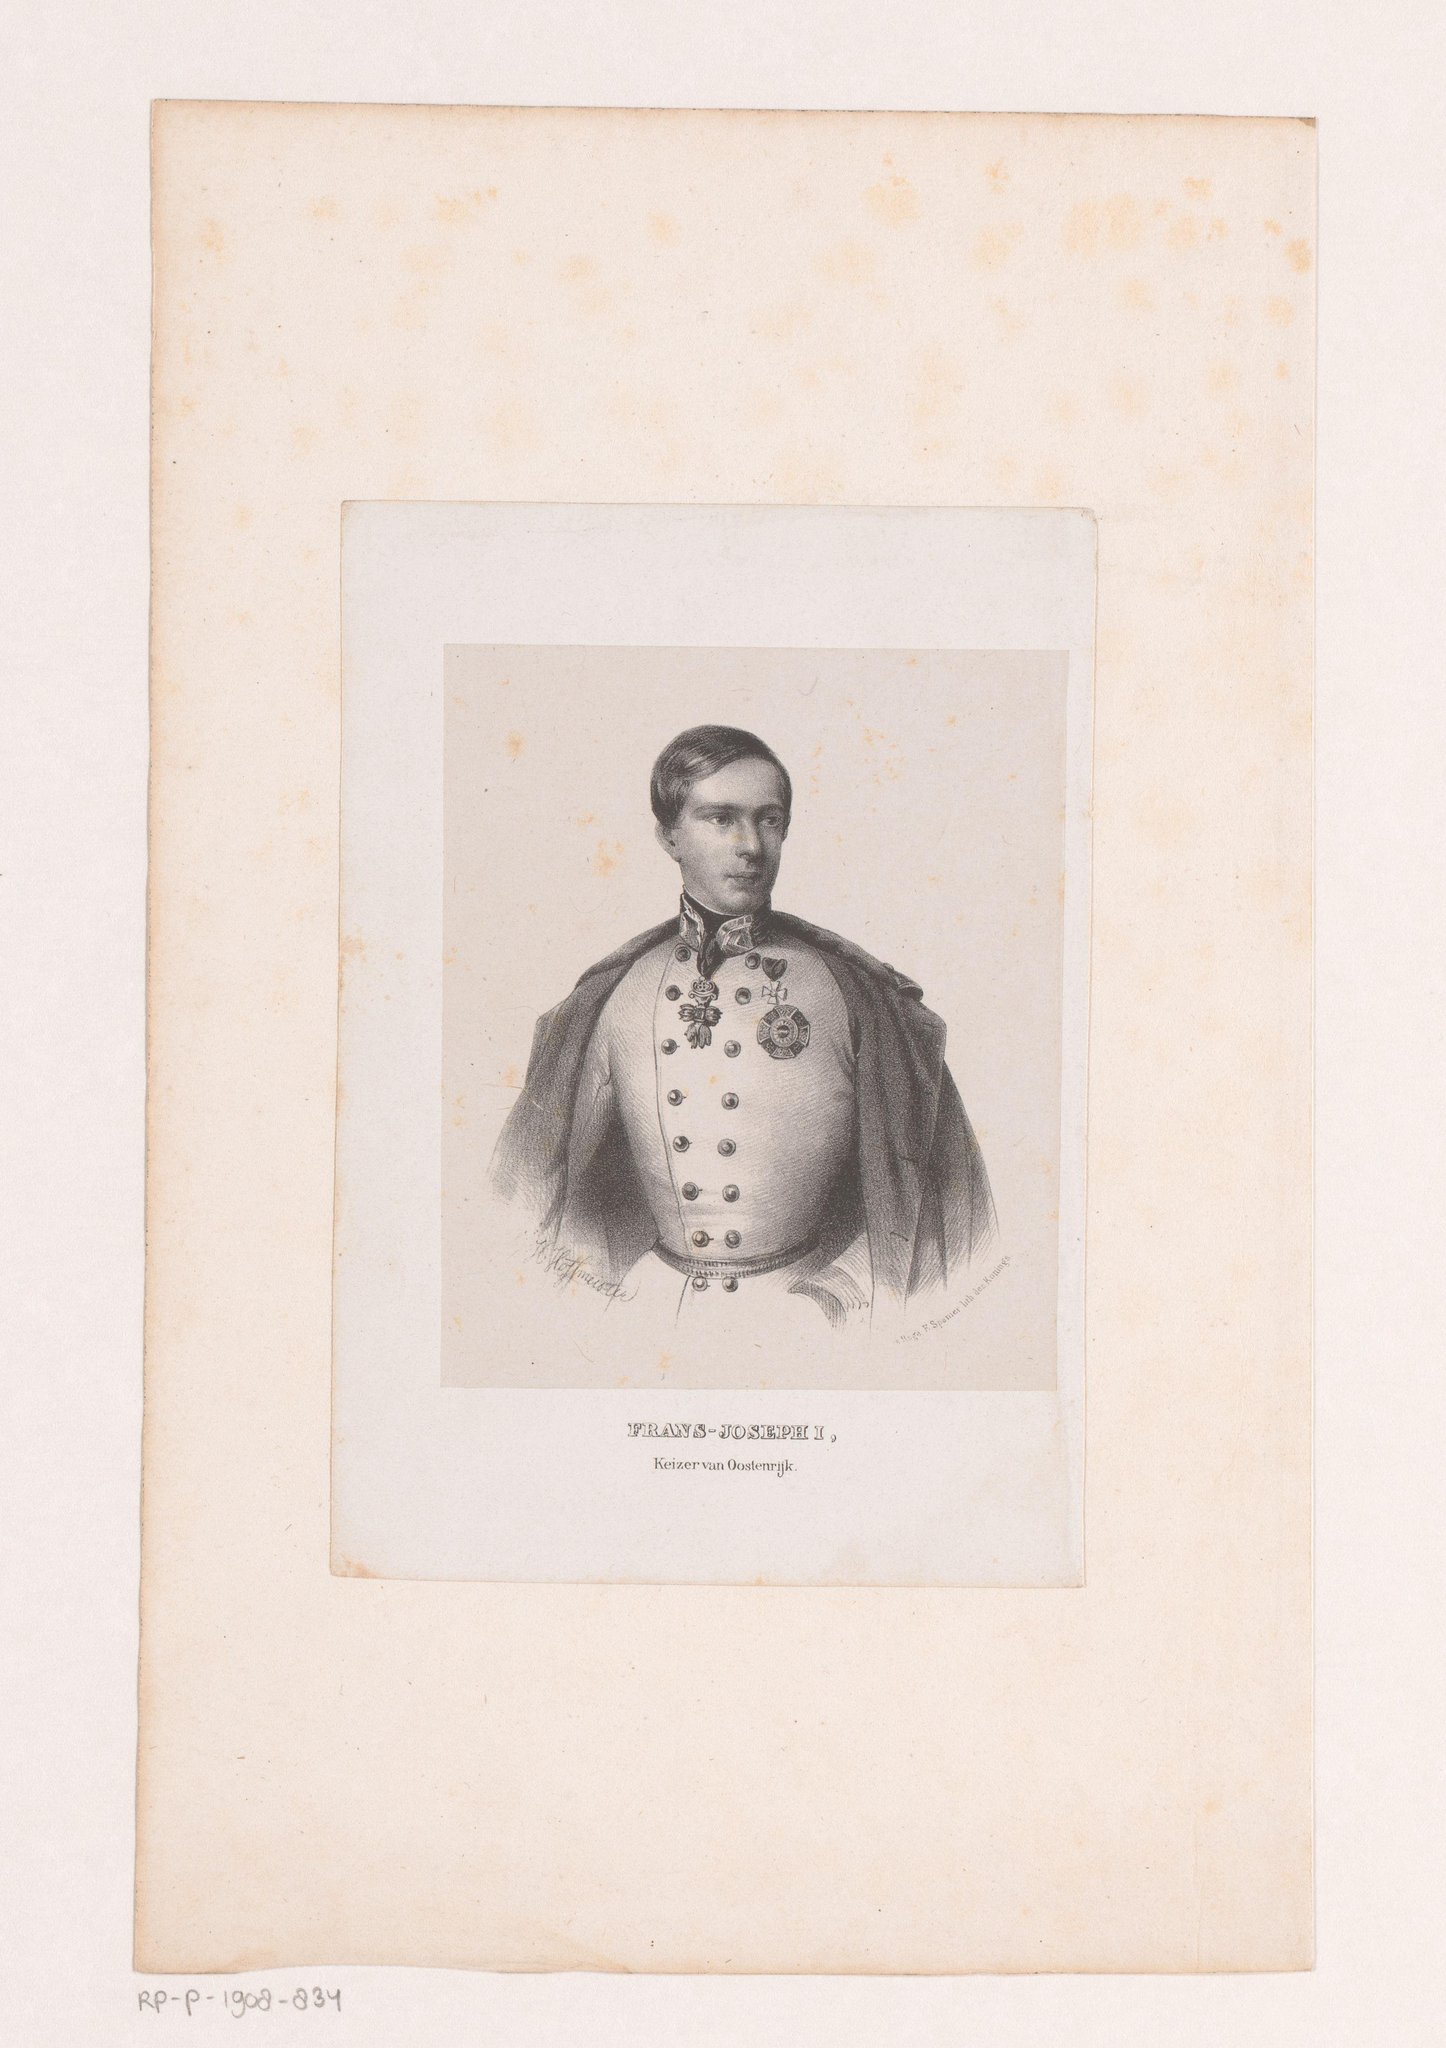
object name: print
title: Portret van Frans Jozef I van Oostenrijk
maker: johan hendrik hoffmeister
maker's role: print maker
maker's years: 1823-1904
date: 1851-1883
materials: paper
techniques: lithograph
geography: the hague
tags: vienna, historical persons (+ half-length portrait)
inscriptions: collector's mark: Lugt 2228